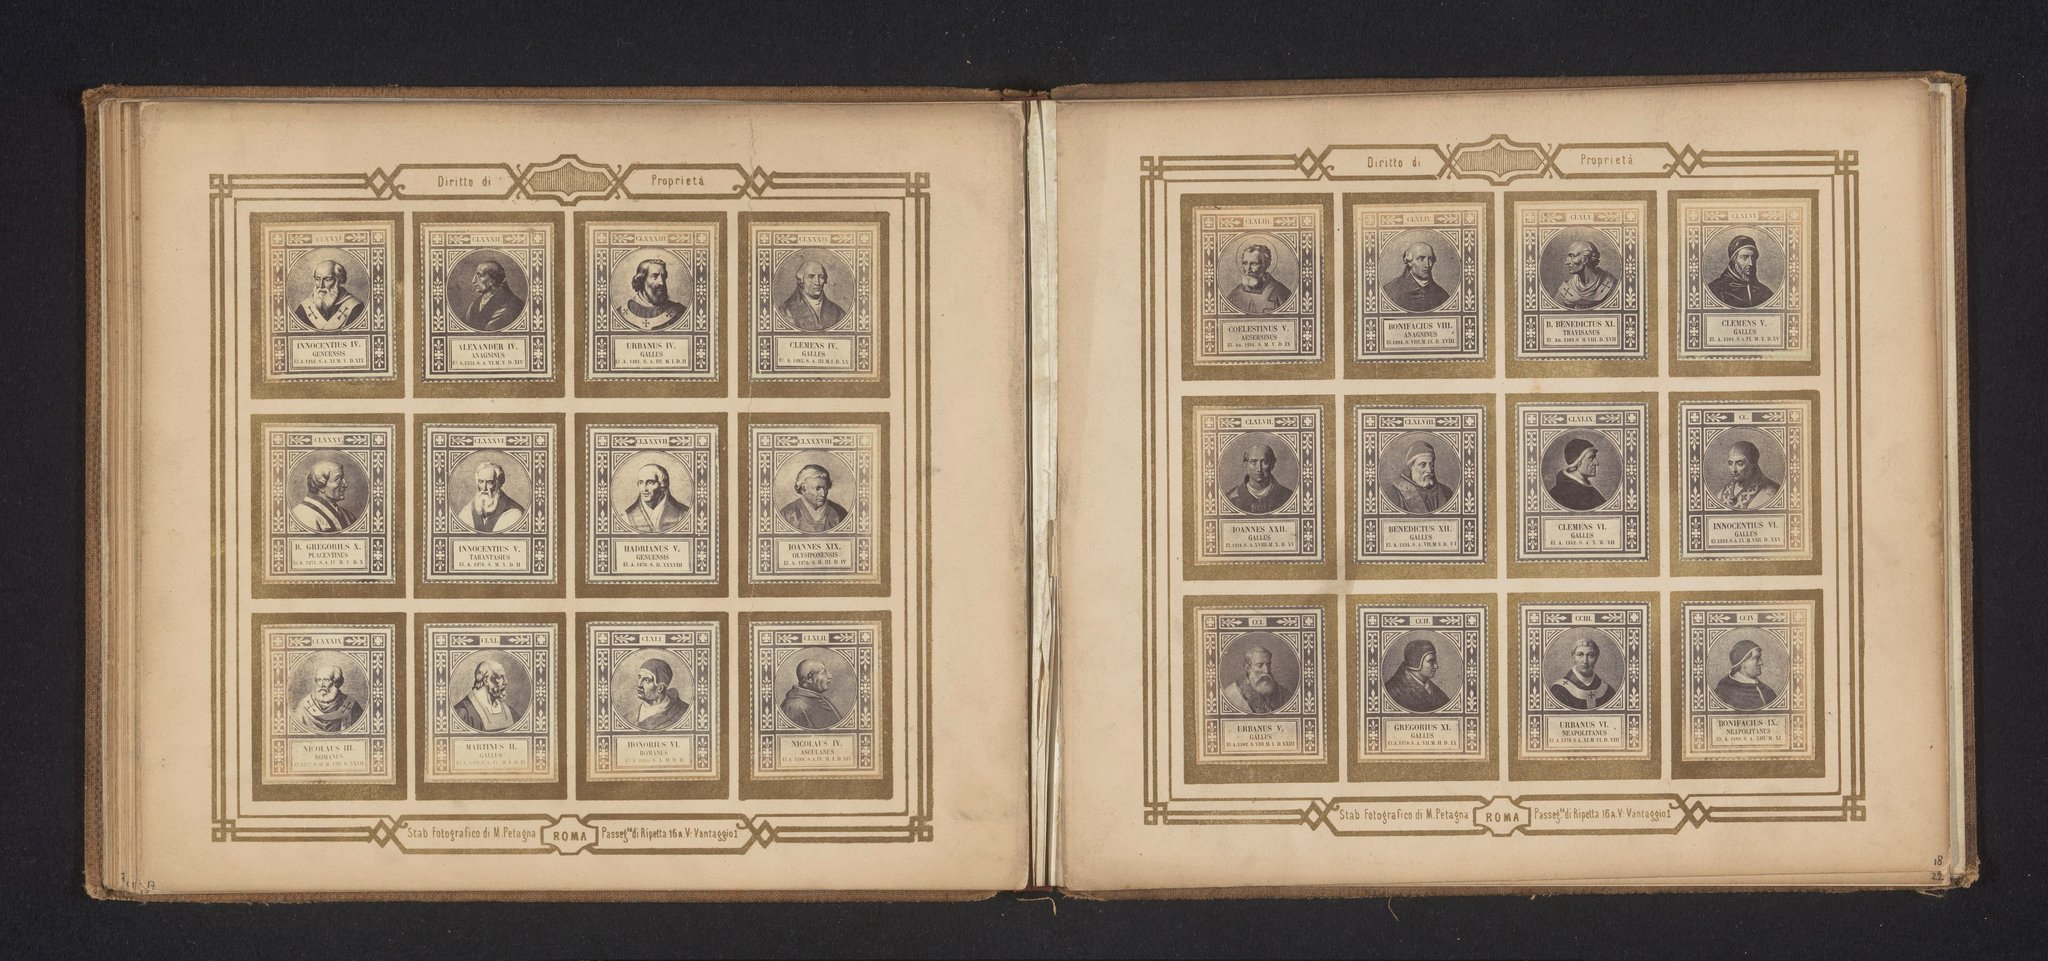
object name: reproduction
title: Fotoreproductie van twaalf portretten van pausen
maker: m. petagna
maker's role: fotograaf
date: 1854-1864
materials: photographic support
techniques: albumen print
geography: rome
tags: pope